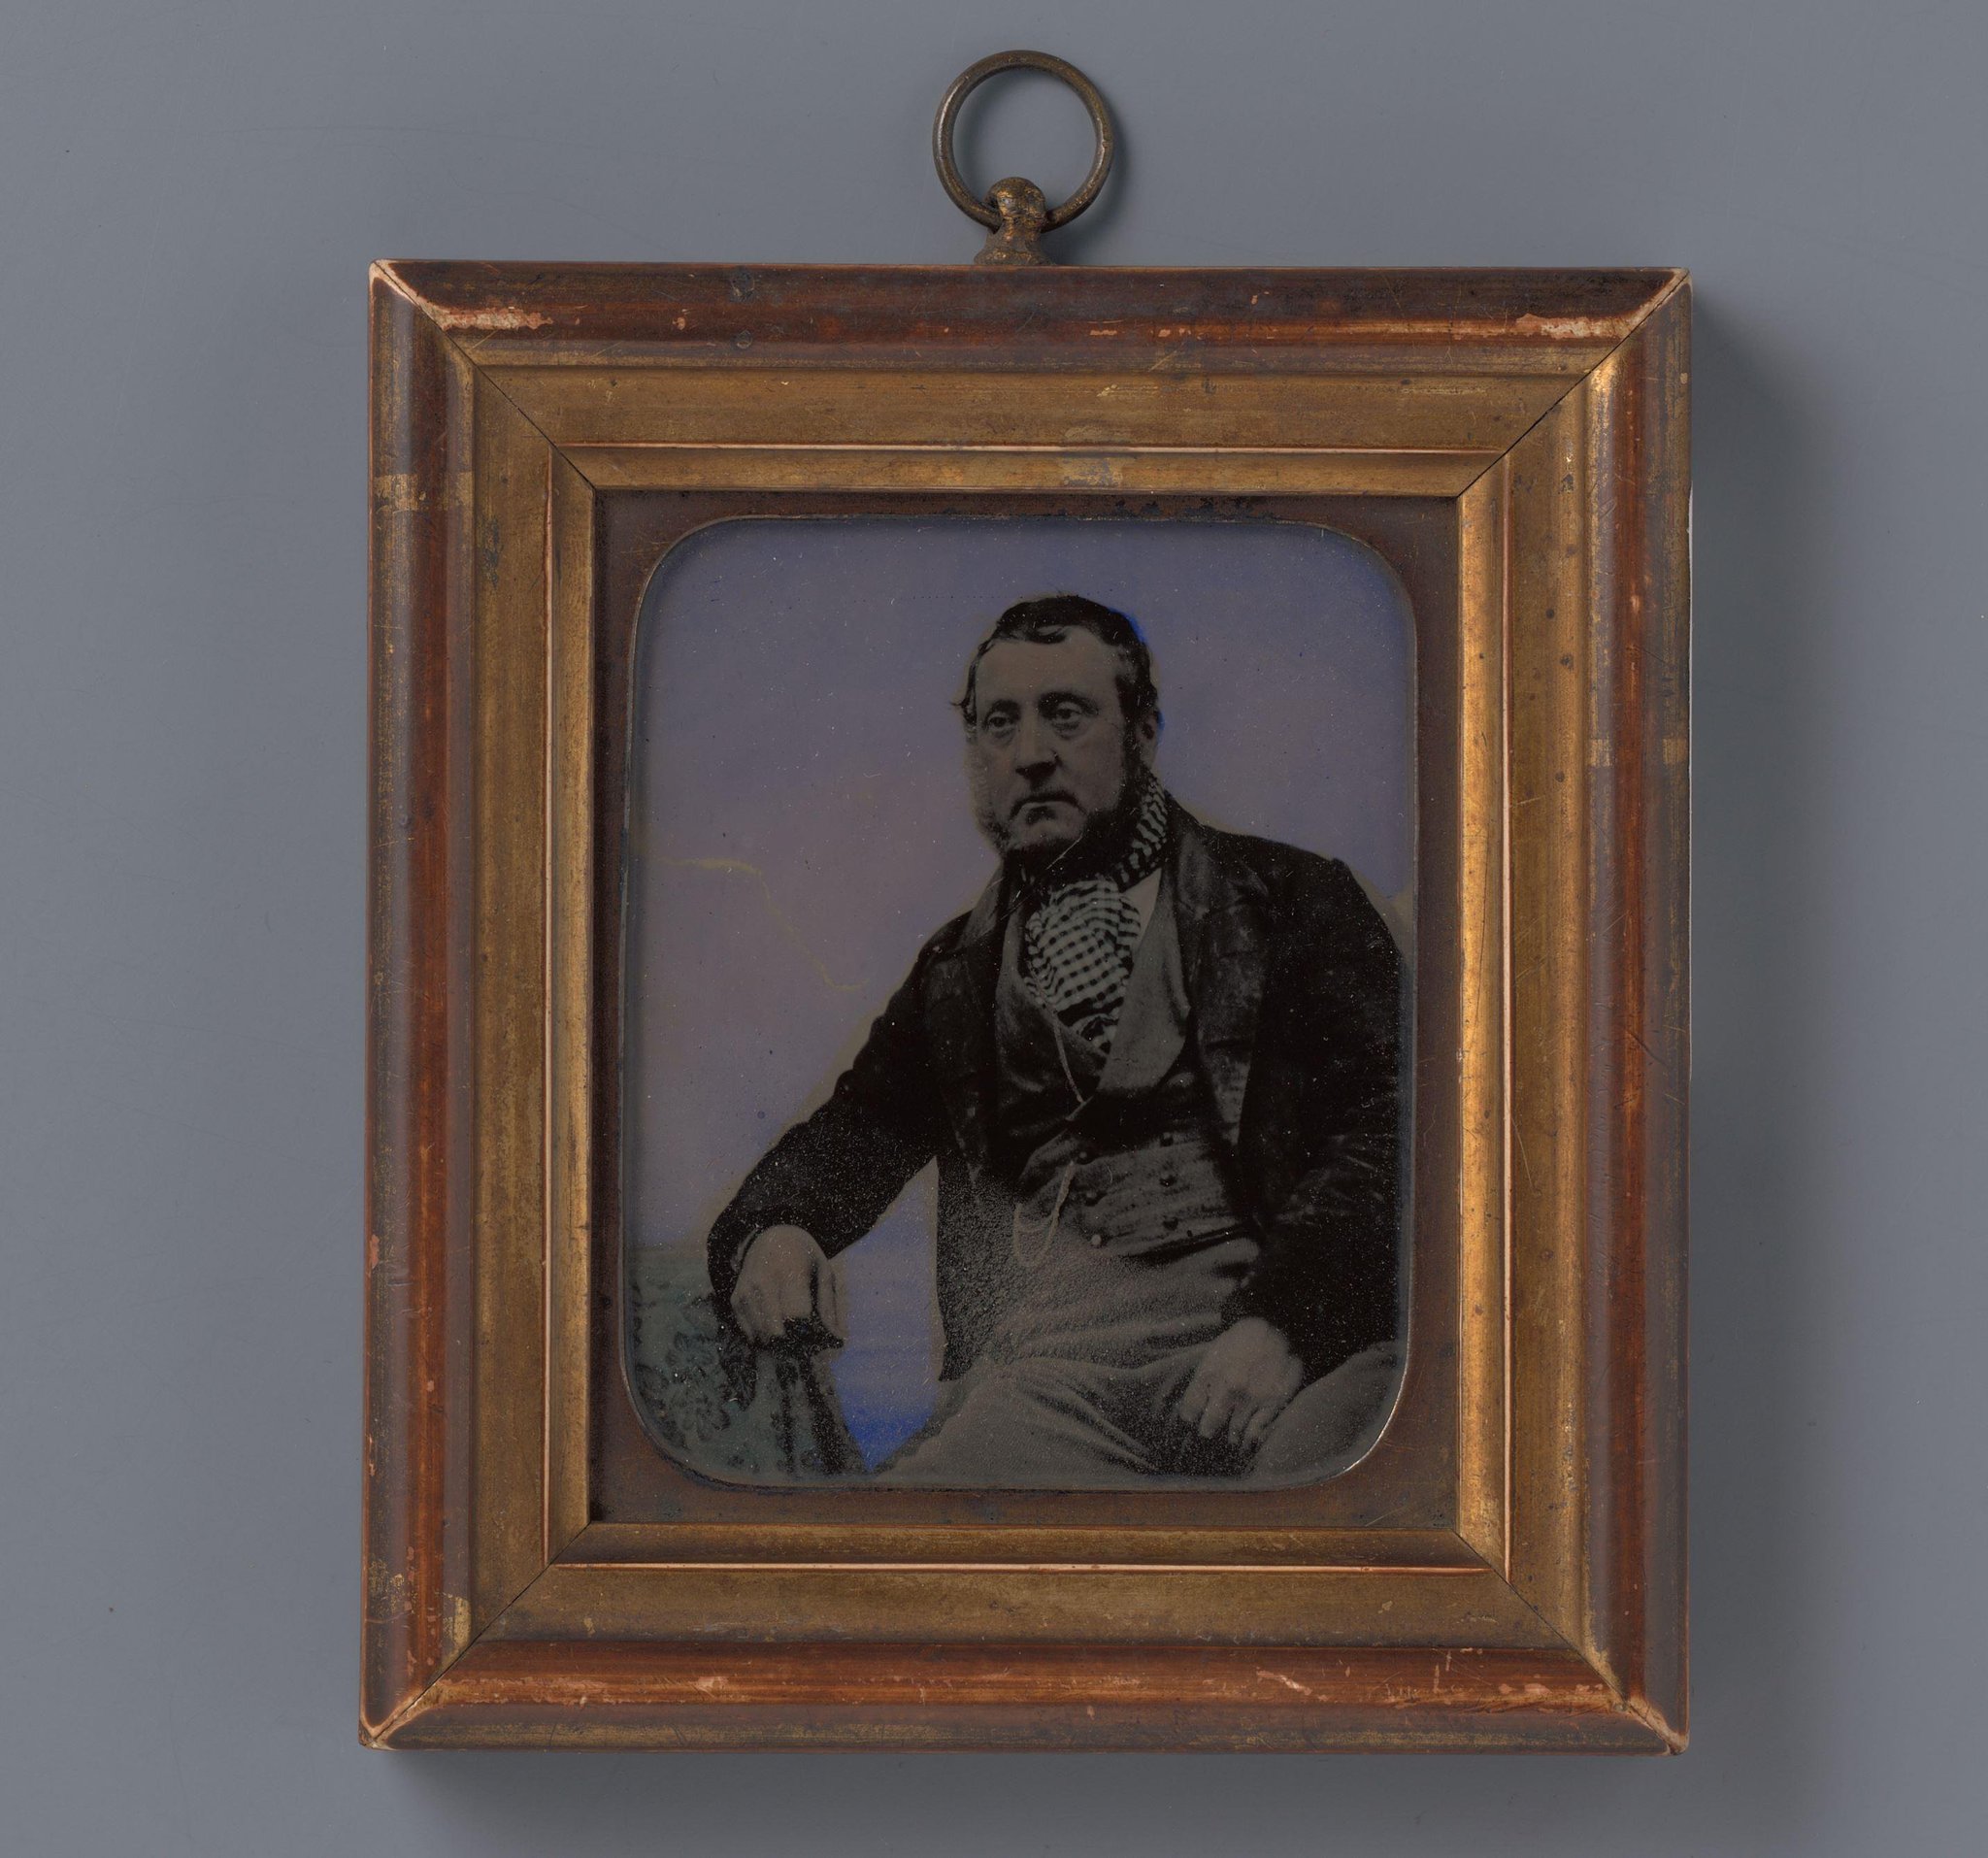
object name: photograph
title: Portret van een zittende man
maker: Anonymous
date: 1855-1870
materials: glass, metal, wood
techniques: ambrotype, hand coloring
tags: sitting figure, adult man, historical persons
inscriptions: annotation: ‘[...] Death us do part/ [...]’